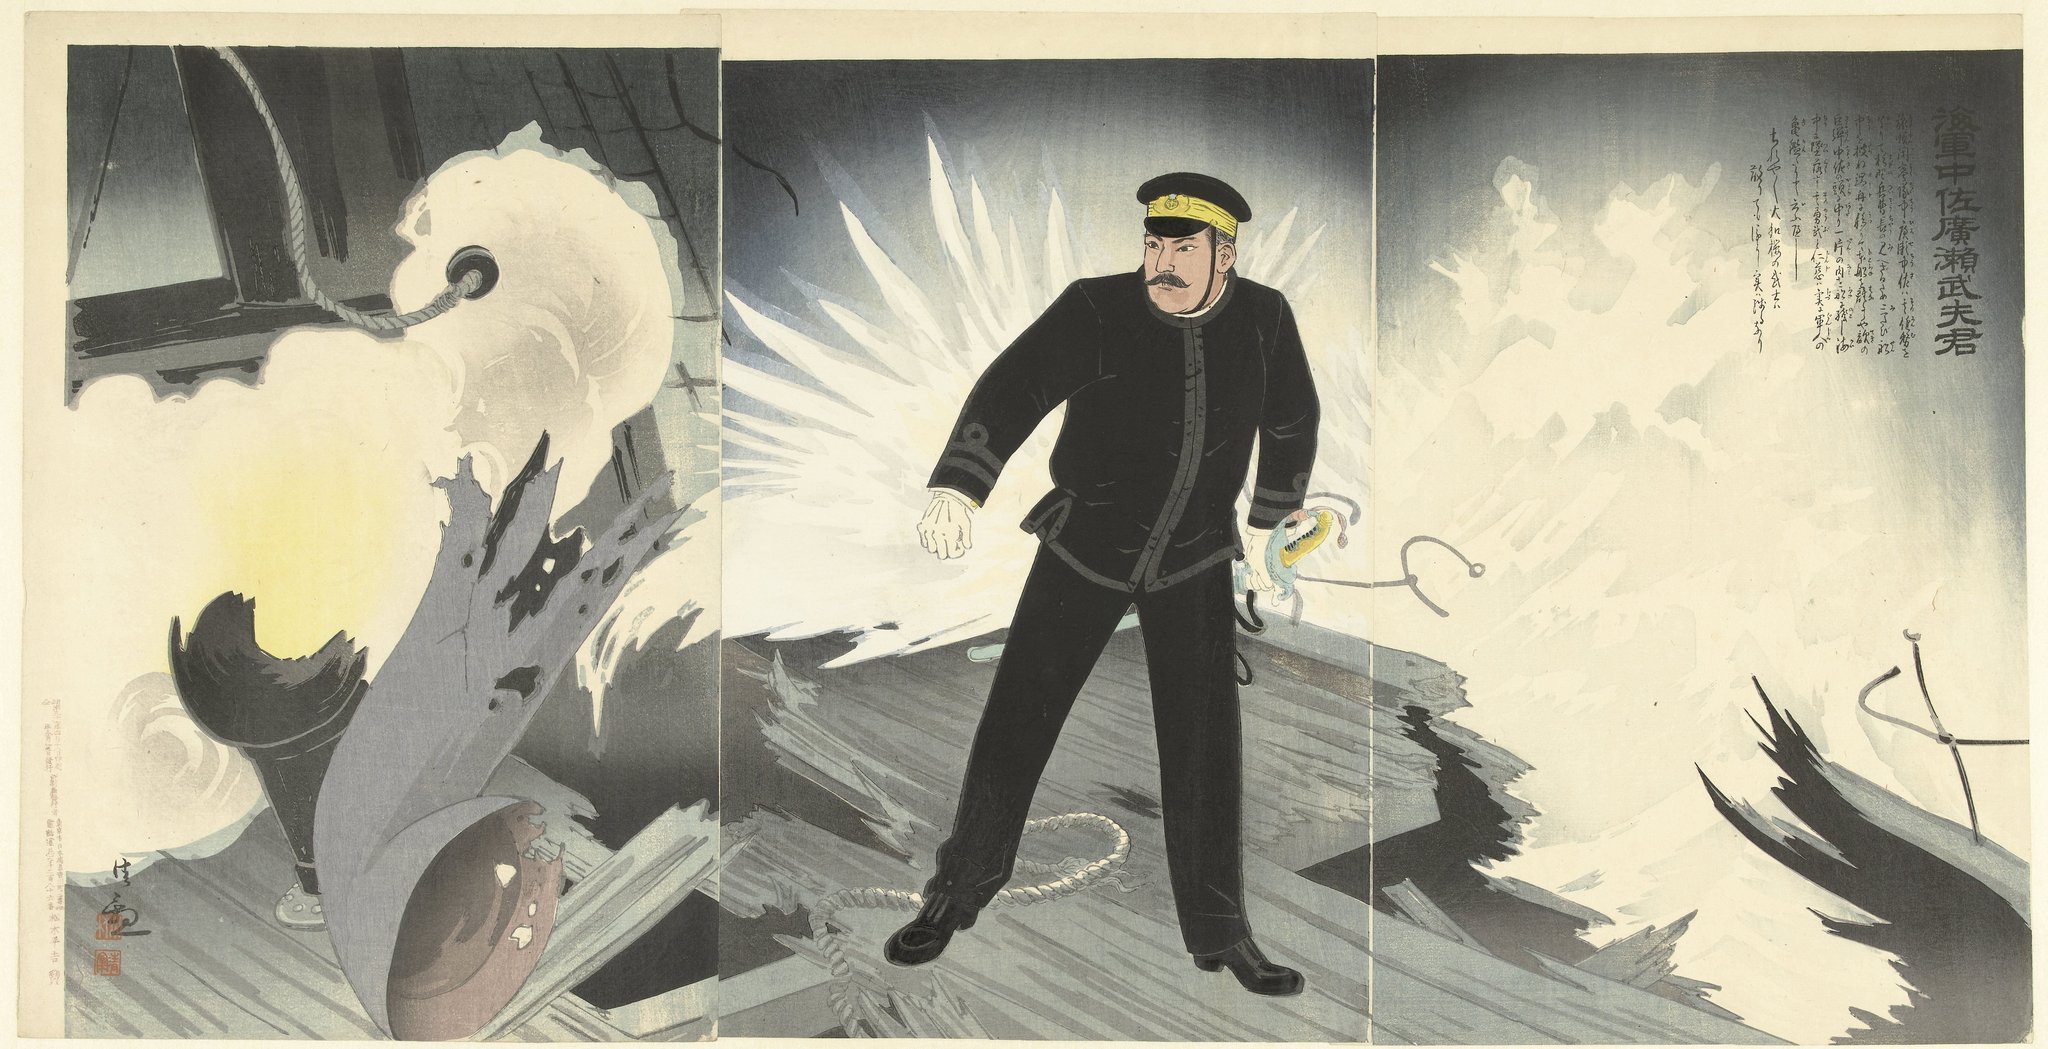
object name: triptych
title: De kapitein-luitenant ter zee Takeo Hirose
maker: kobayashi kiyochika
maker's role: print maker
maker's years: 1847-1915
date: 1904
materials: paper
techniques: woodcut, polish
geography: japan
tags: war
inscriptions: collector's mark: Lugt 2760, collector's mark: Lugt 2228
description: Kapitein-luitenant ter zee Takeo Hirose, met linker hand zijn zwaard omklemmend, op het exploderende schip de Fukuimaru.